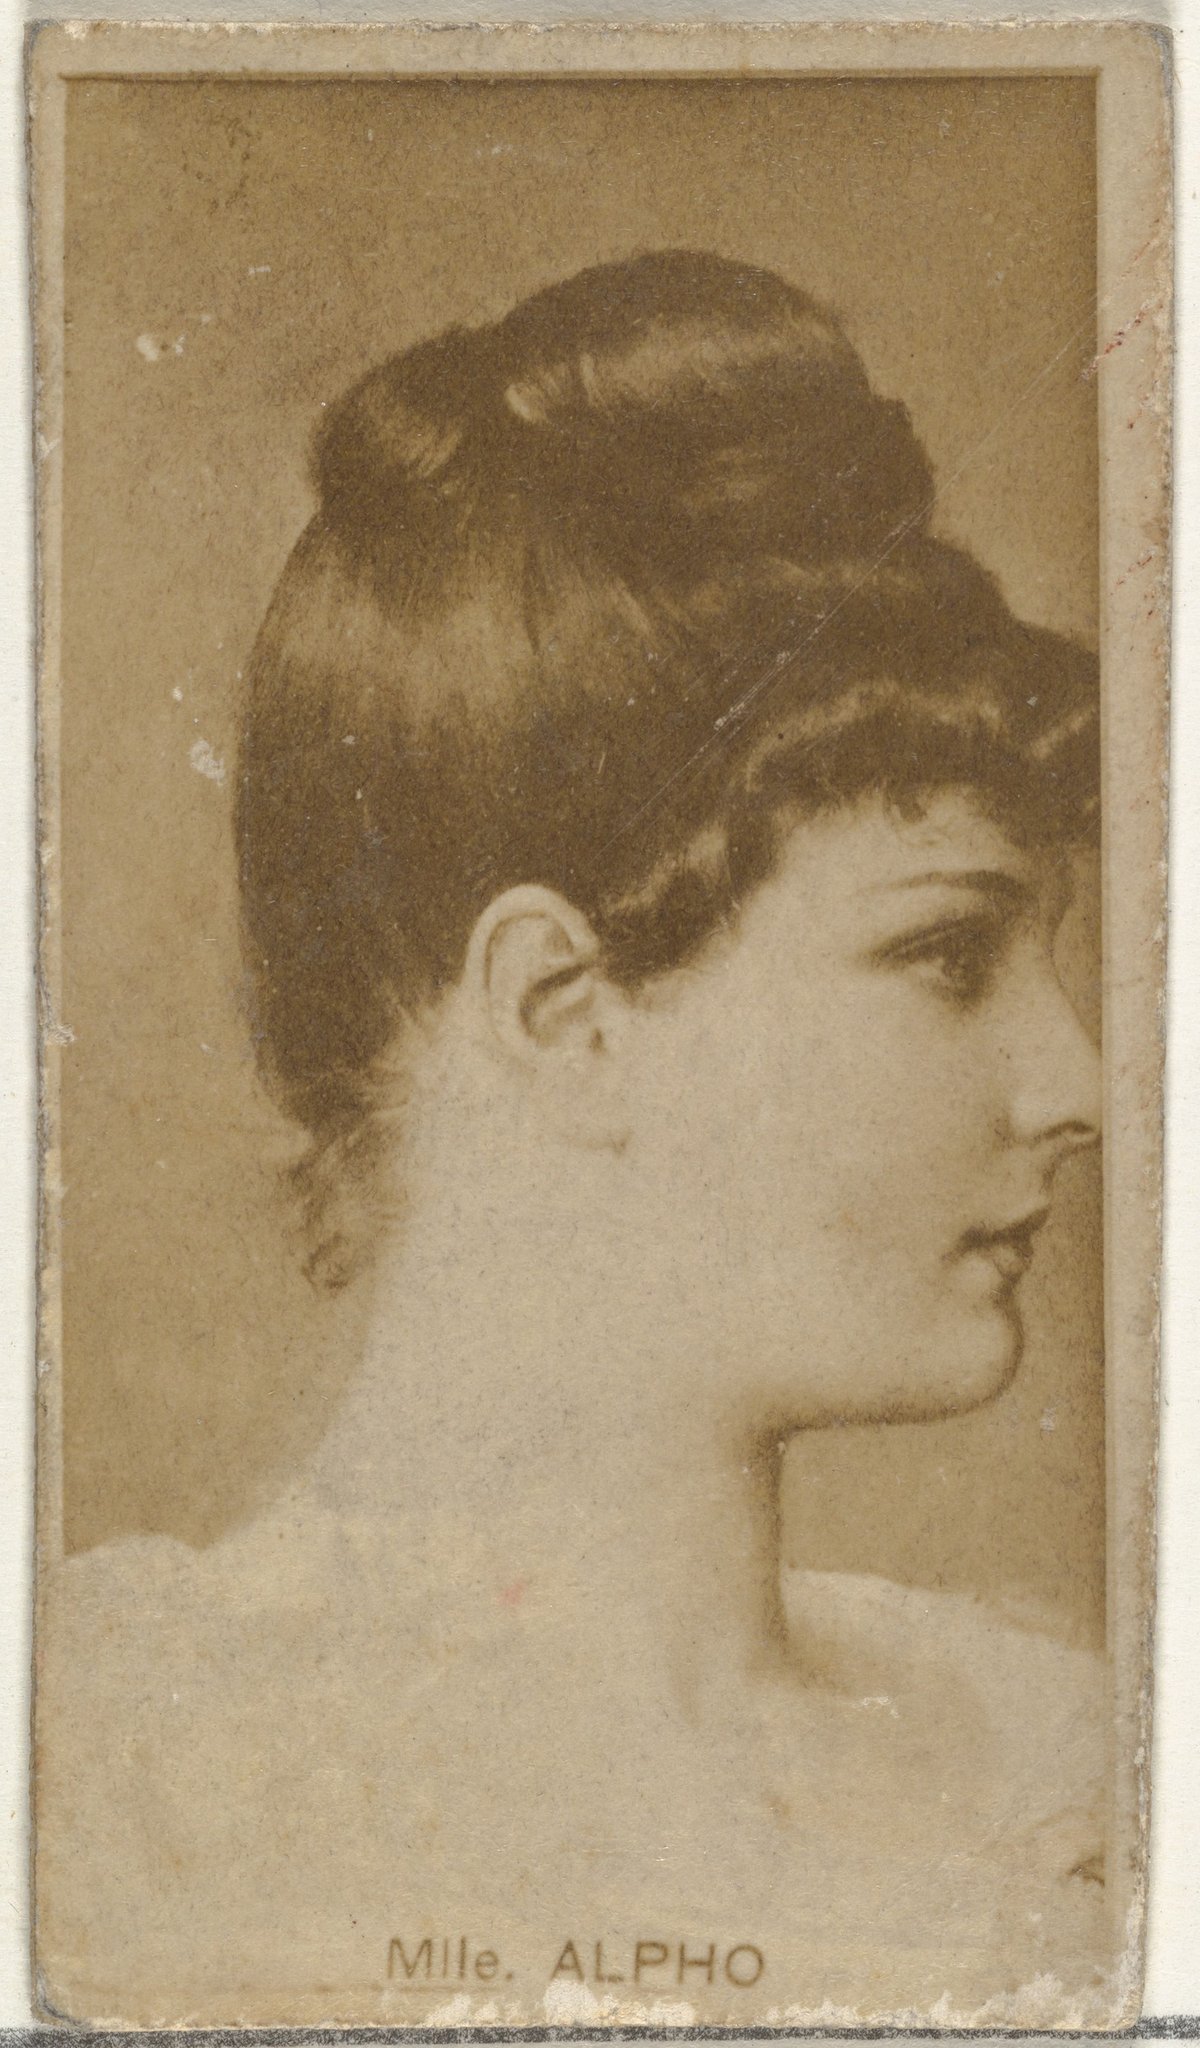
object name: photograph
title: Mlle. Alpho, from the Actors and Actresses series (N145-8) issued by Duke Sons & Co. to promote Duke Cigarettes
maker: w. duke, sons & co.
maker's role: publisher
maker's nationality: american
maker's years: 1870-1920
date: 1891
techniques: albumen silver print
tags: portraits,women,actresses